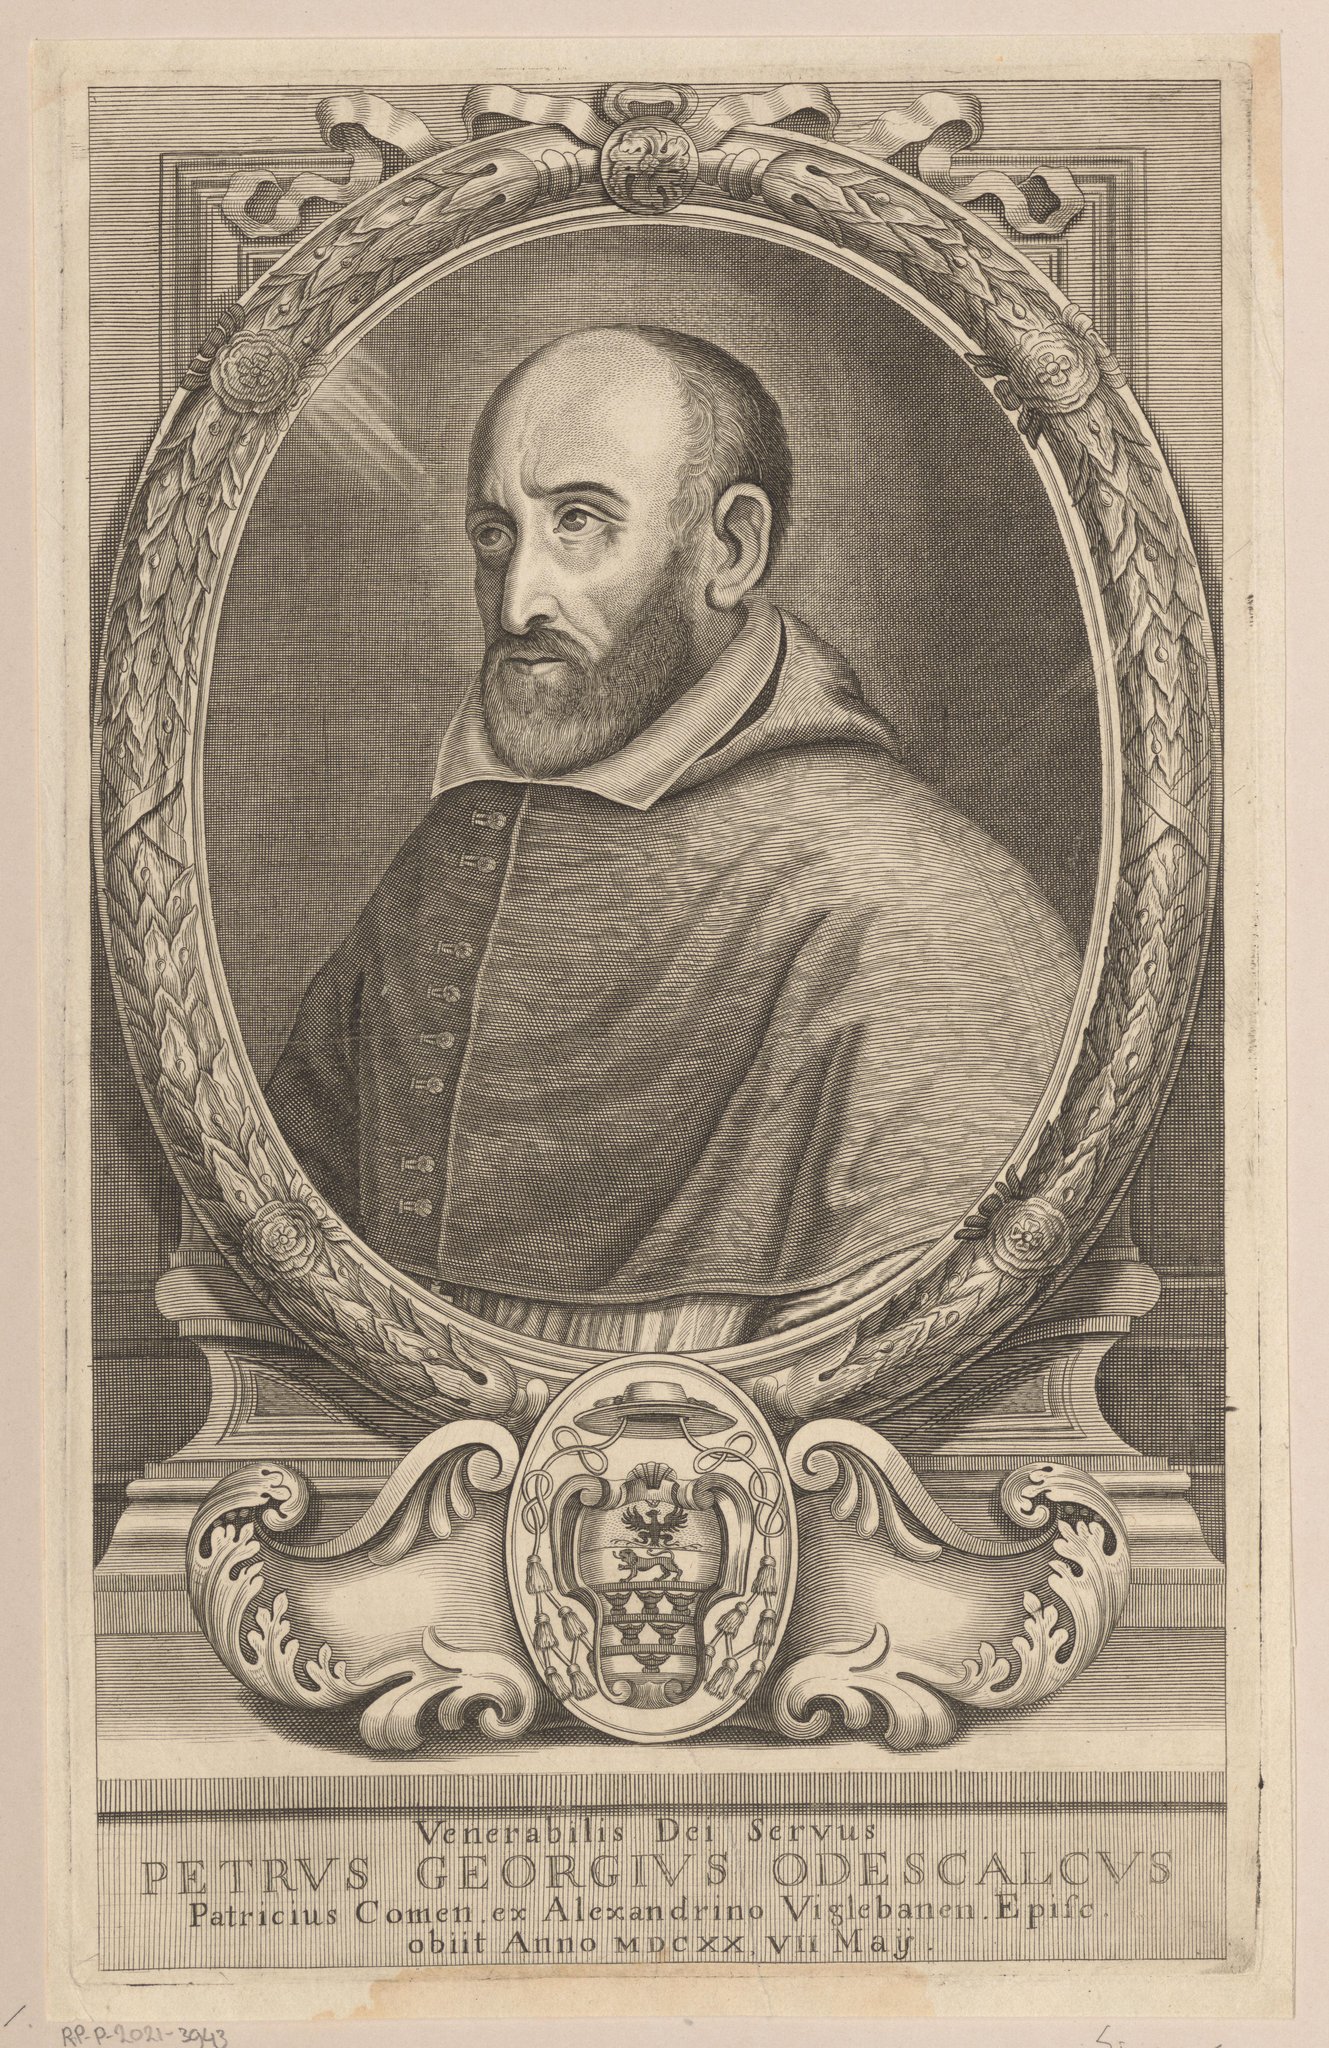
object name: print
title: Portret van Peter Georg Odescaldi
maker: Anonymous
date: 1685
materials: paper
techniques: engraving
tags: historical persons, armorial bearing, heraldry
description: Prent mogelijk uit: Papenbroeck, Daniel van. Paralipomena (...) in conatu chronico-historico ad catalogum Romanorum pontificum. Antwerpen: Michiel Cnobbaert, 1685.